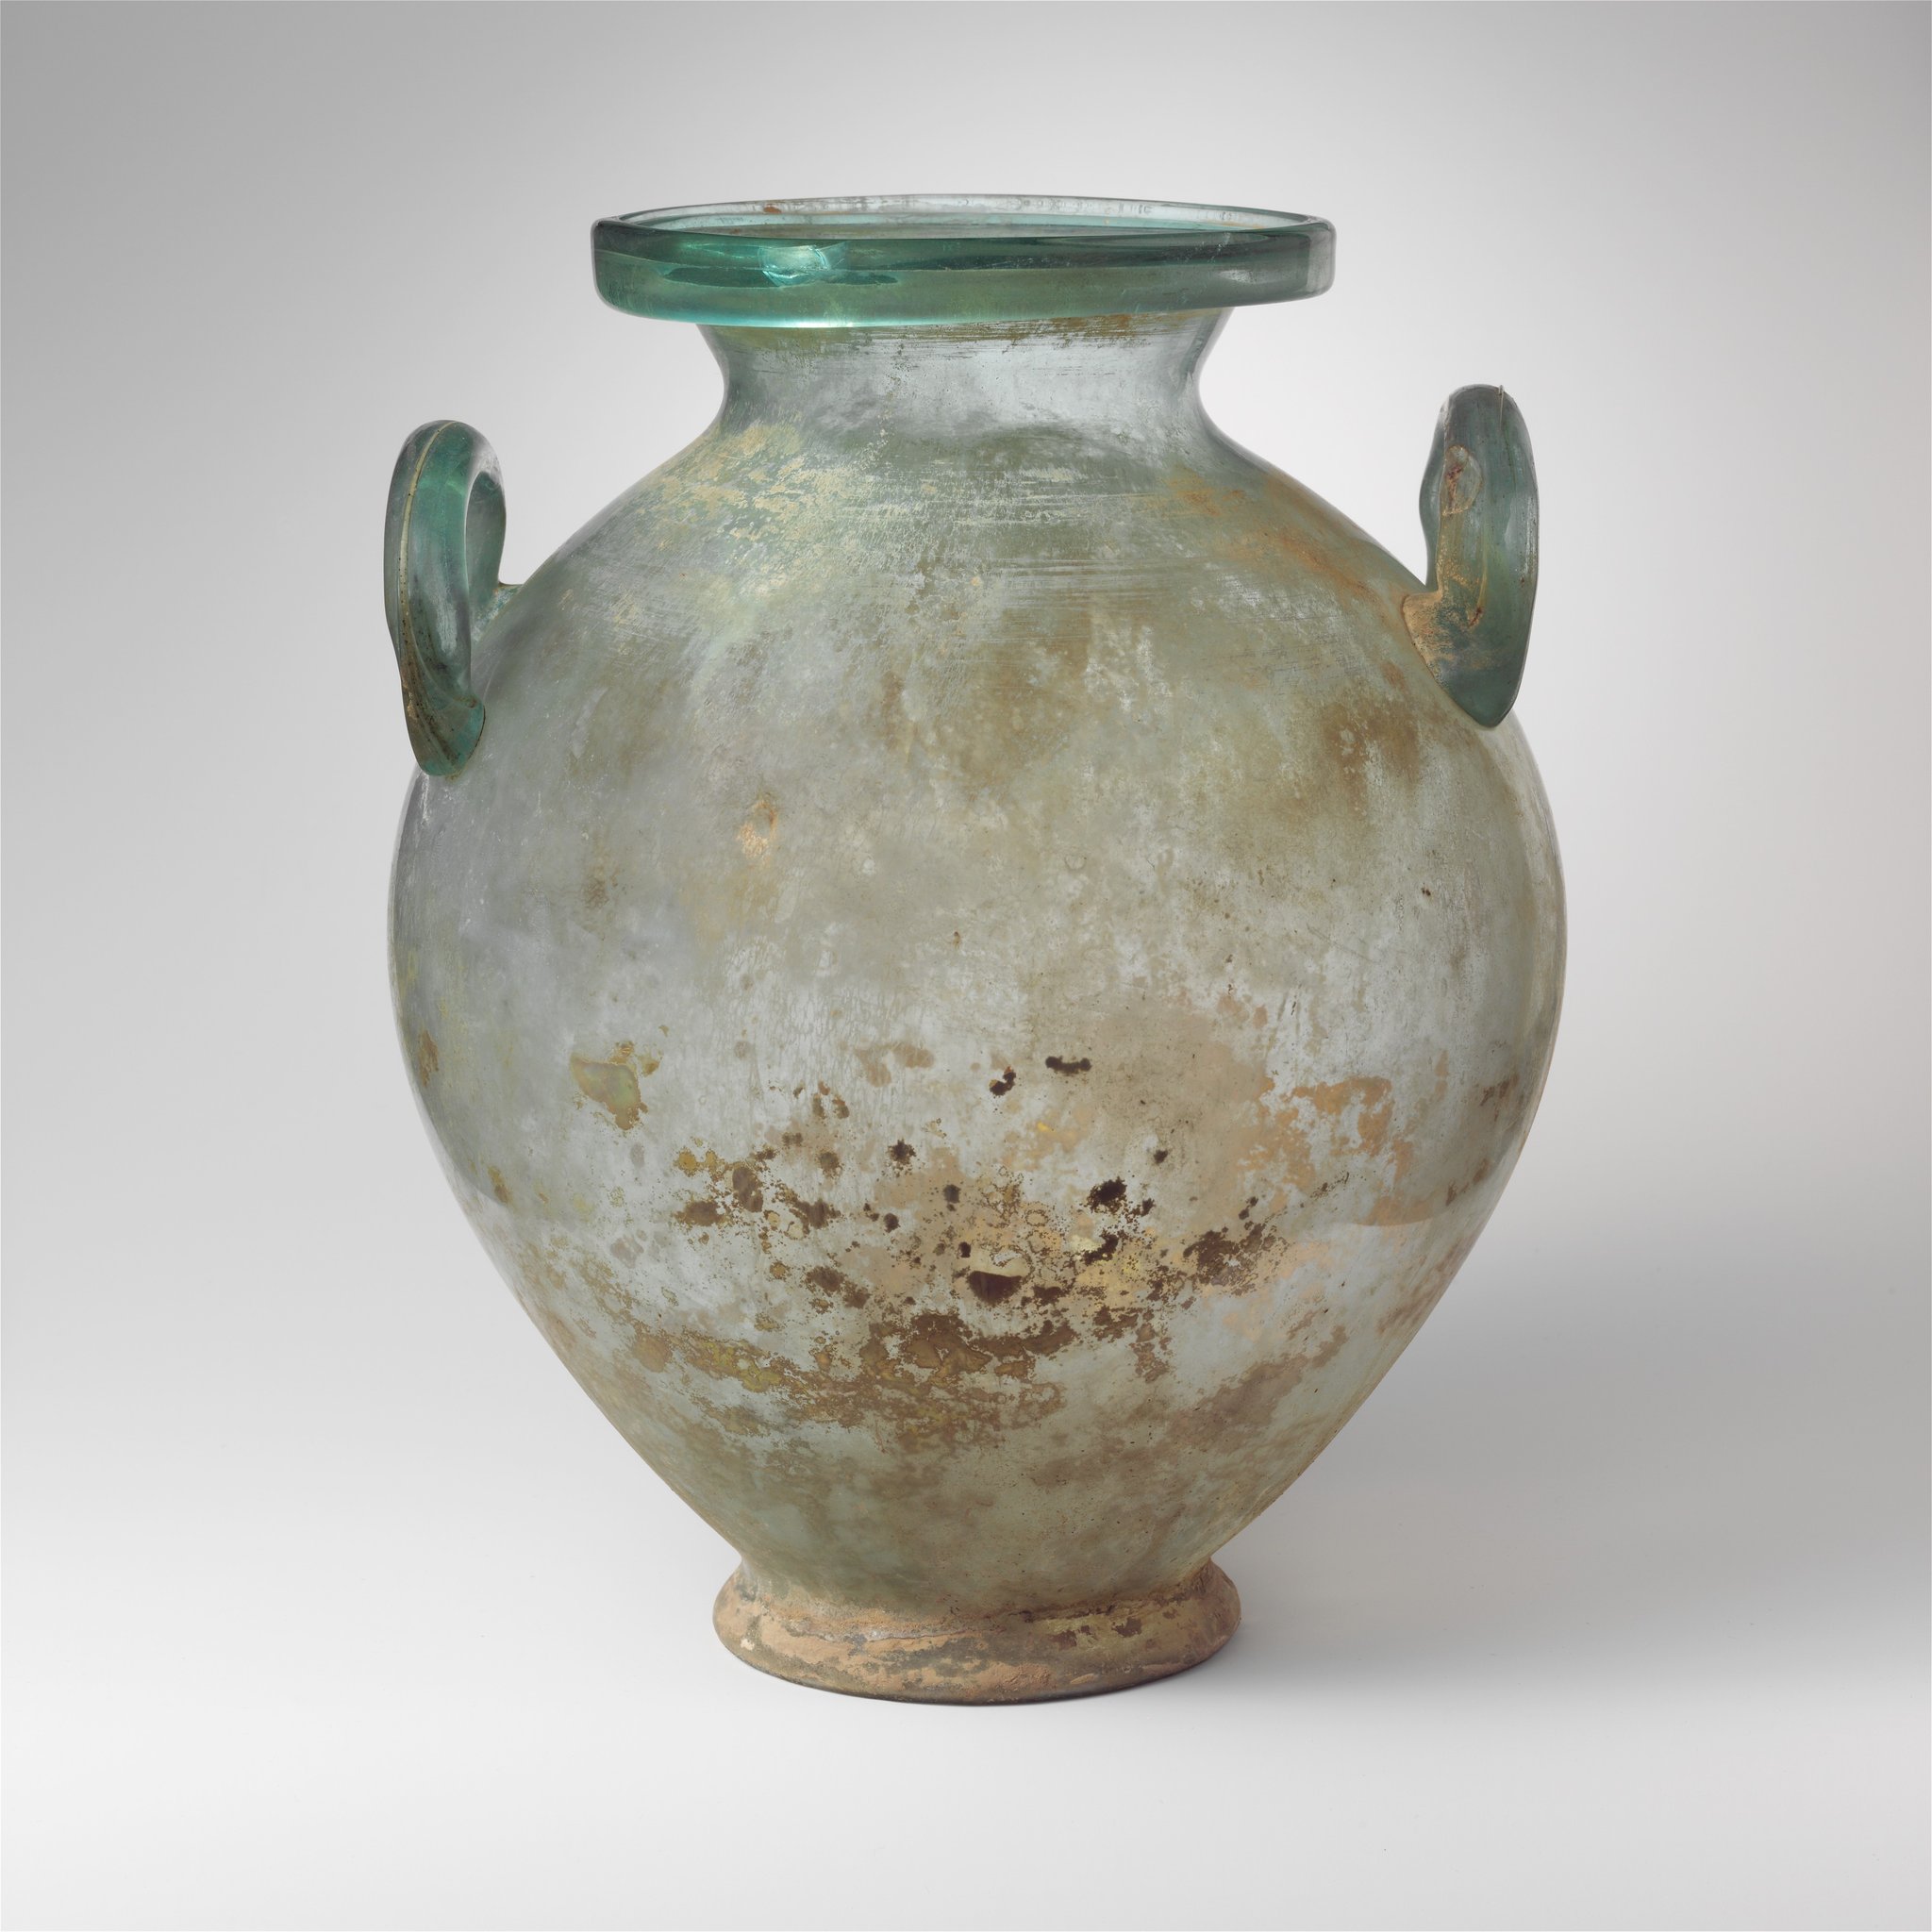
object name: urn with two handle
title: Glass cinerary urn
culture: roman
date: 34-200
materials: glass